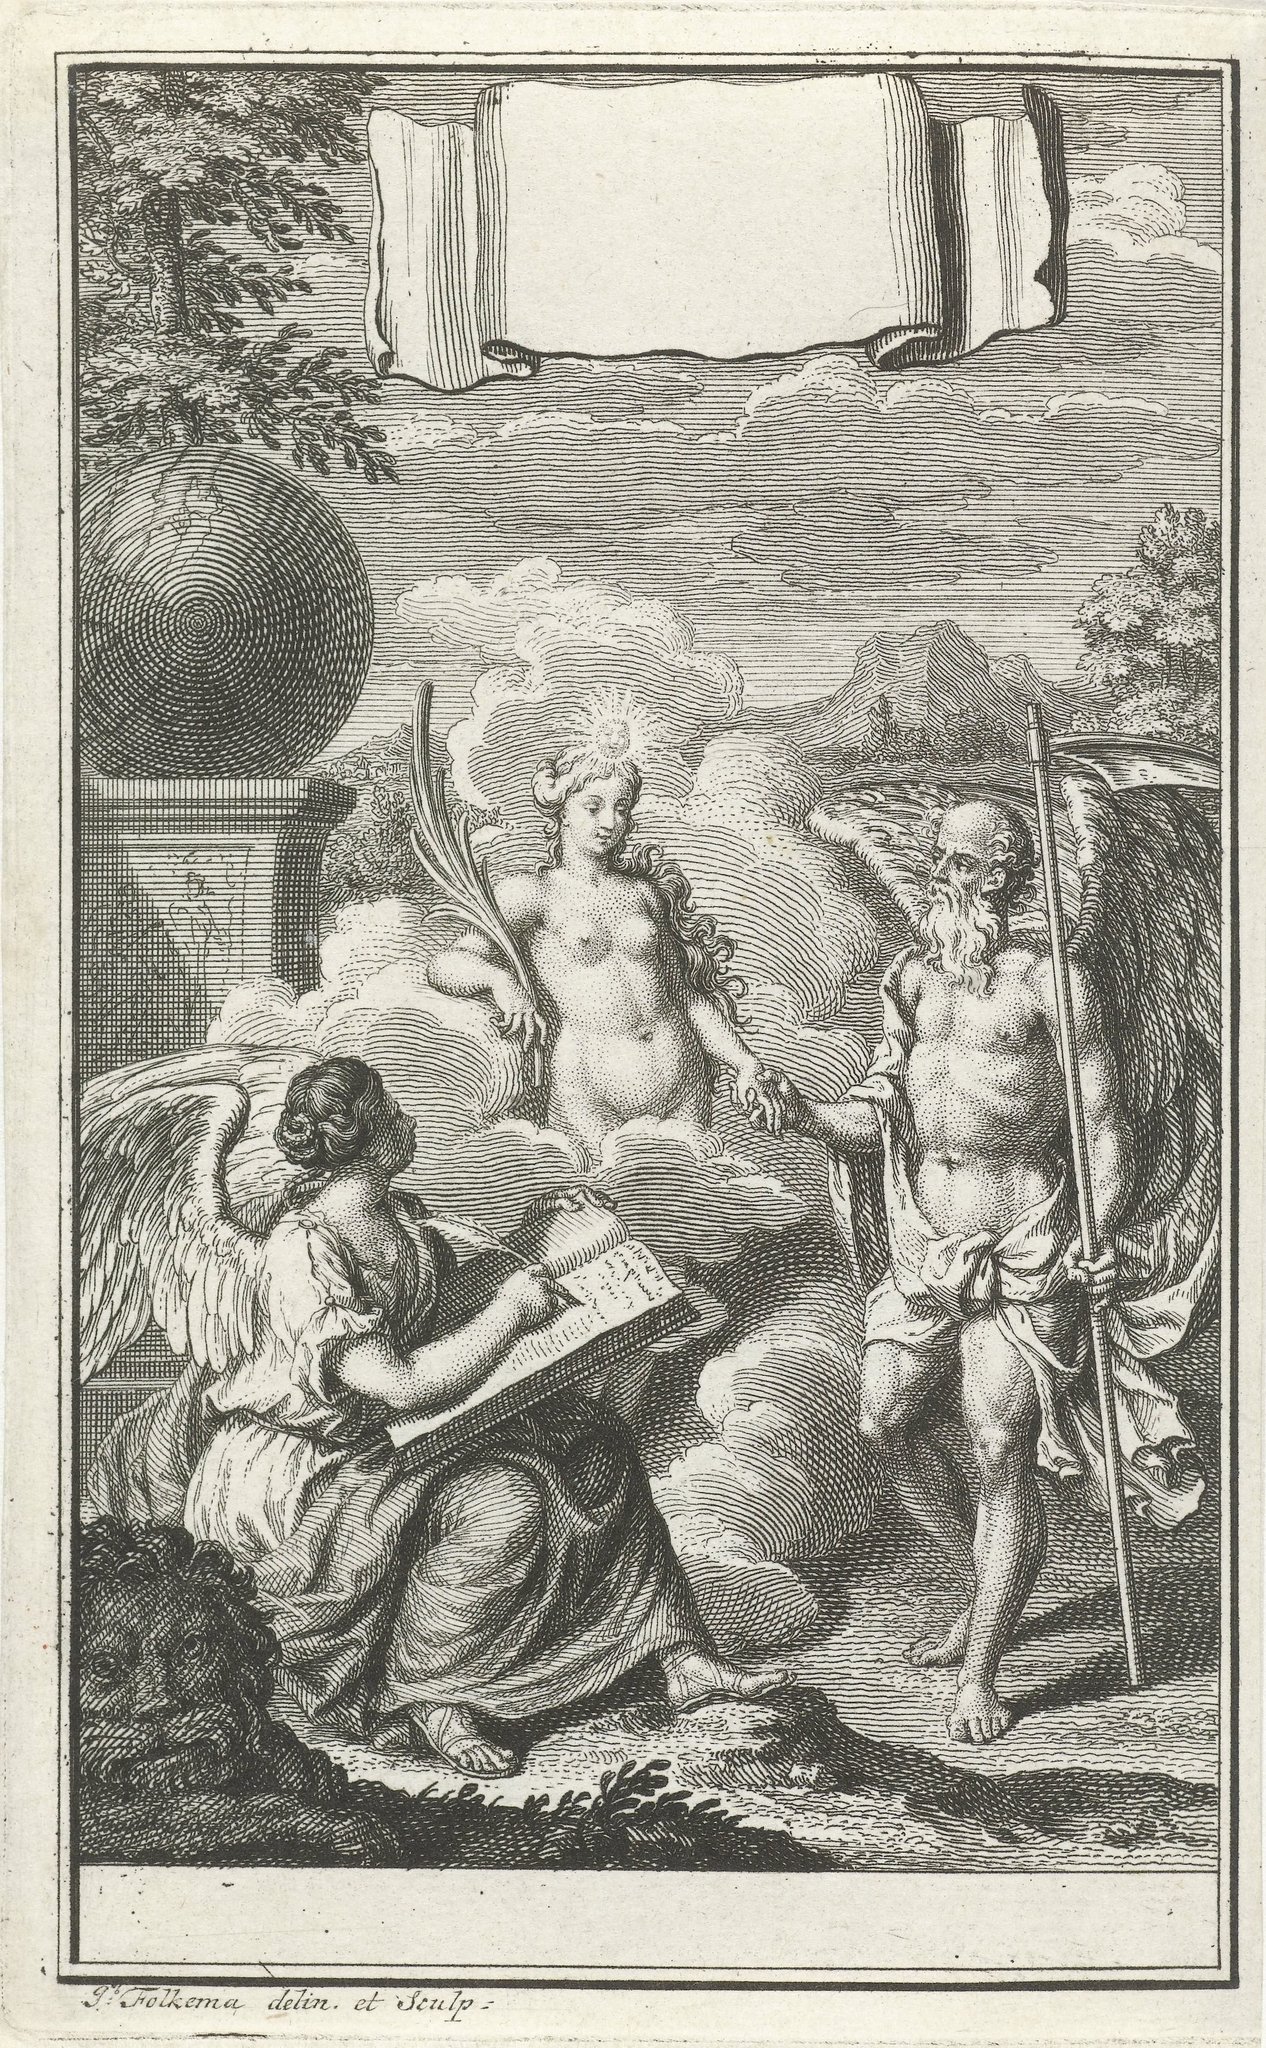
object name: print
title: Vader Tijd onthult de Waarheid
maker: jacob folkema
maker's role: draughtsman, print maker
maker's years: 1692-1767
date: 1702-1767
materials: paper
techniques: etching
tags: 'historia'; 'historia' (ripa), time revealing truth; time carrying truth aloft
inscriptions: collector's mark: Lugt 240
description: De personificatie van Geschiedenis legt met een schrijfveer in een boek vast wat ze voor haar ogen ziet gebeuren. Ze kijkt naar Vader Tijd die hand in hand staat met Waarheid, een naakte vrouw omgeven door wolken. Het hoofd van Waarheid is getooid met een stralende zon, in haar handen houdt ze een palmtak vast.